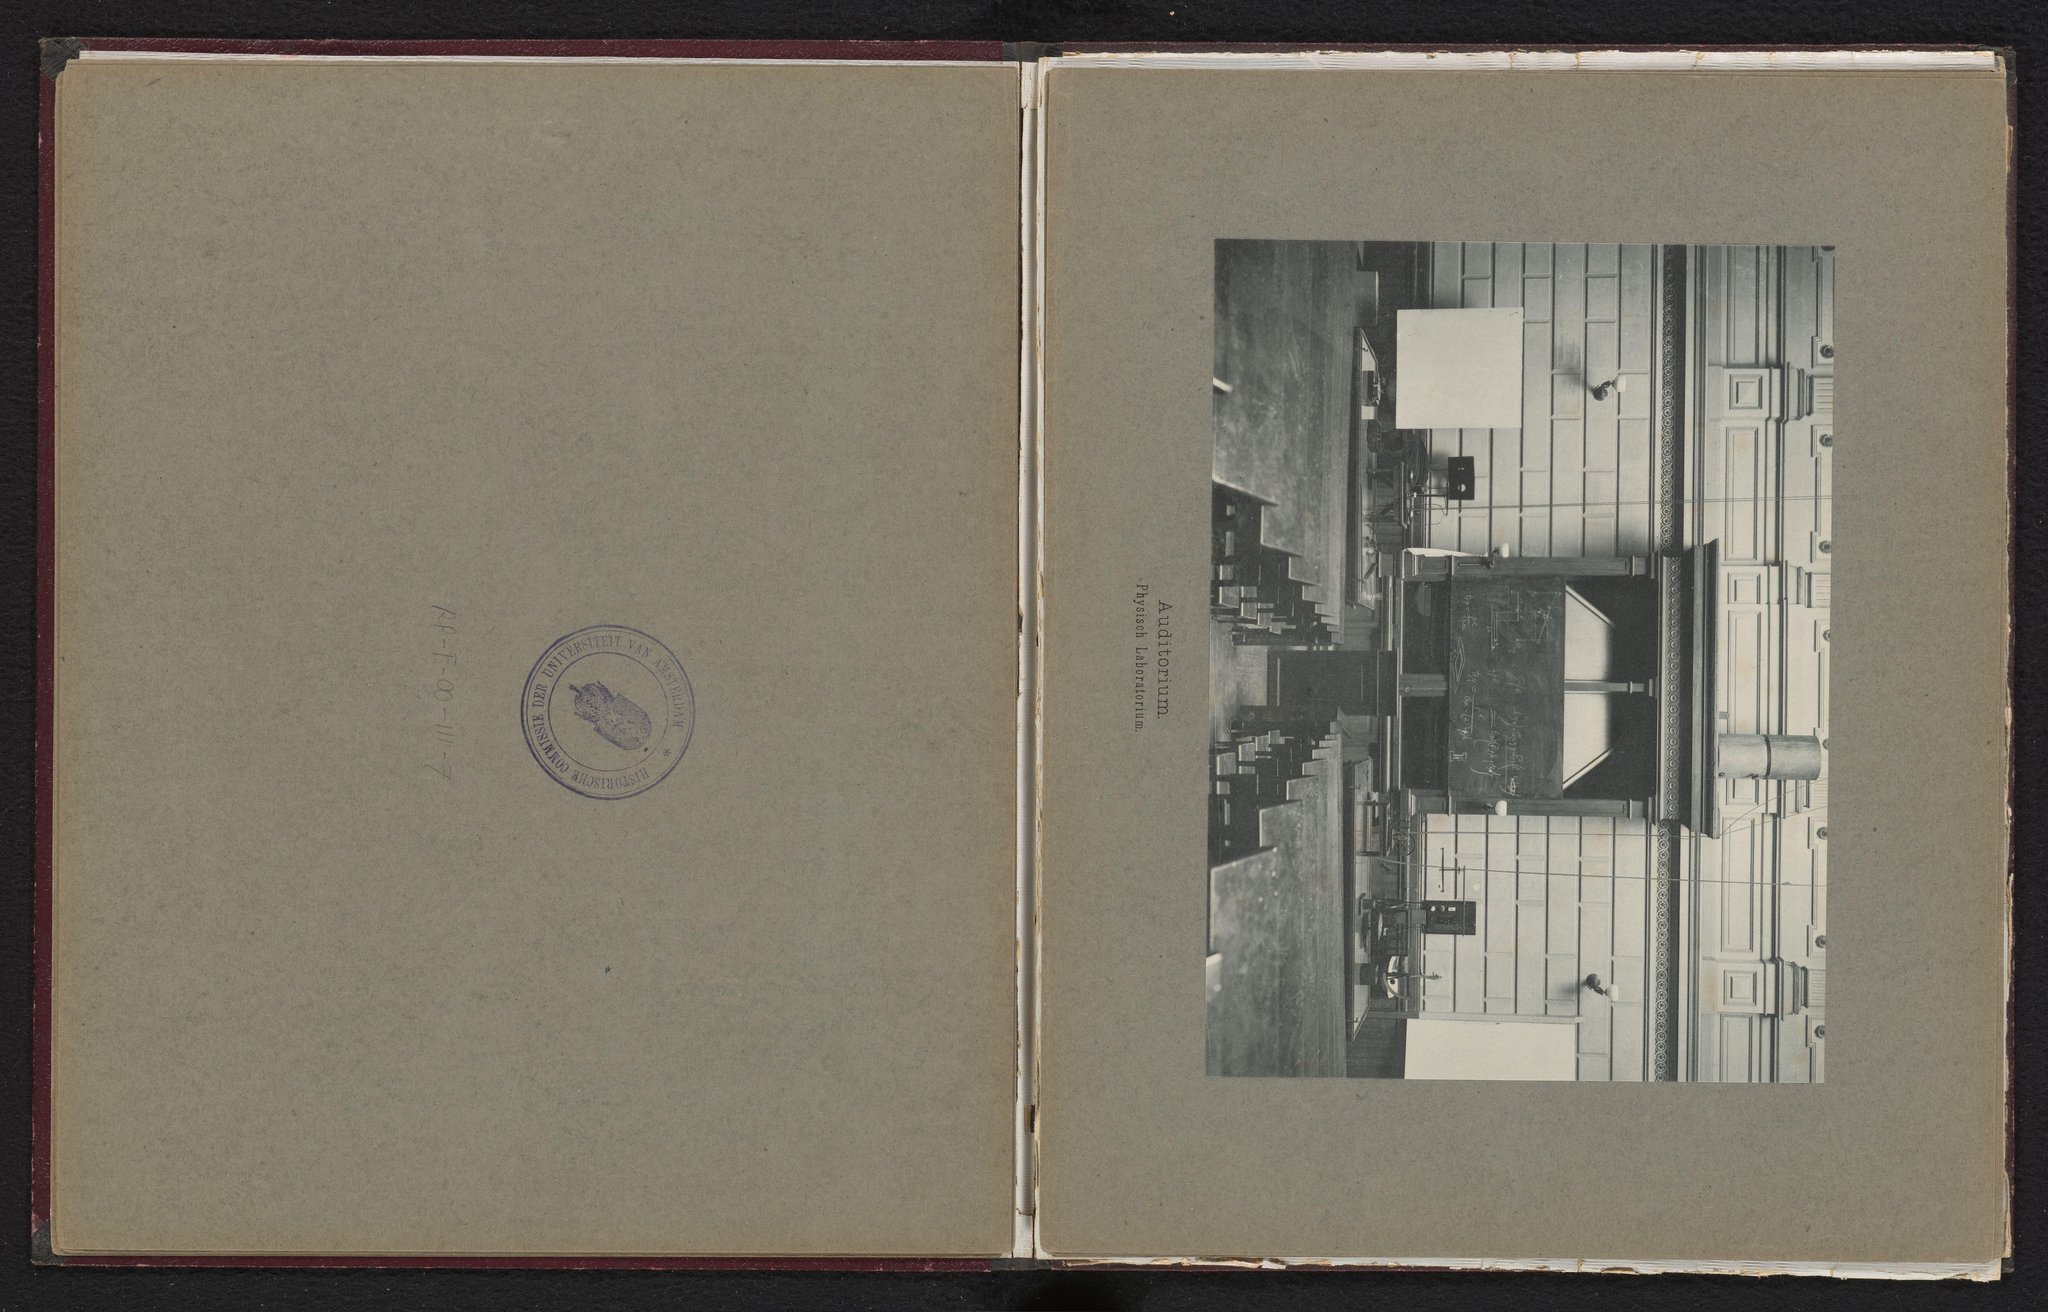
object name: photomechanical print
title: Auditorium van het fysisch laboratorium van de Universiteit van Amsterdam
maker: Anonymous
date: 1902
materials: cardboard, paper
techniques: photograph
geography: amsterdam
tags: university building, college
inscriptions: stamp: ‘HISTORISCHE COMMISSIE DER UNIVERSITEIT VAN AMSTERDAM’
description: Deze prent maakt deel uit van een omslag met vijftien lichtdrukken op twaalf kartonnen bladen.